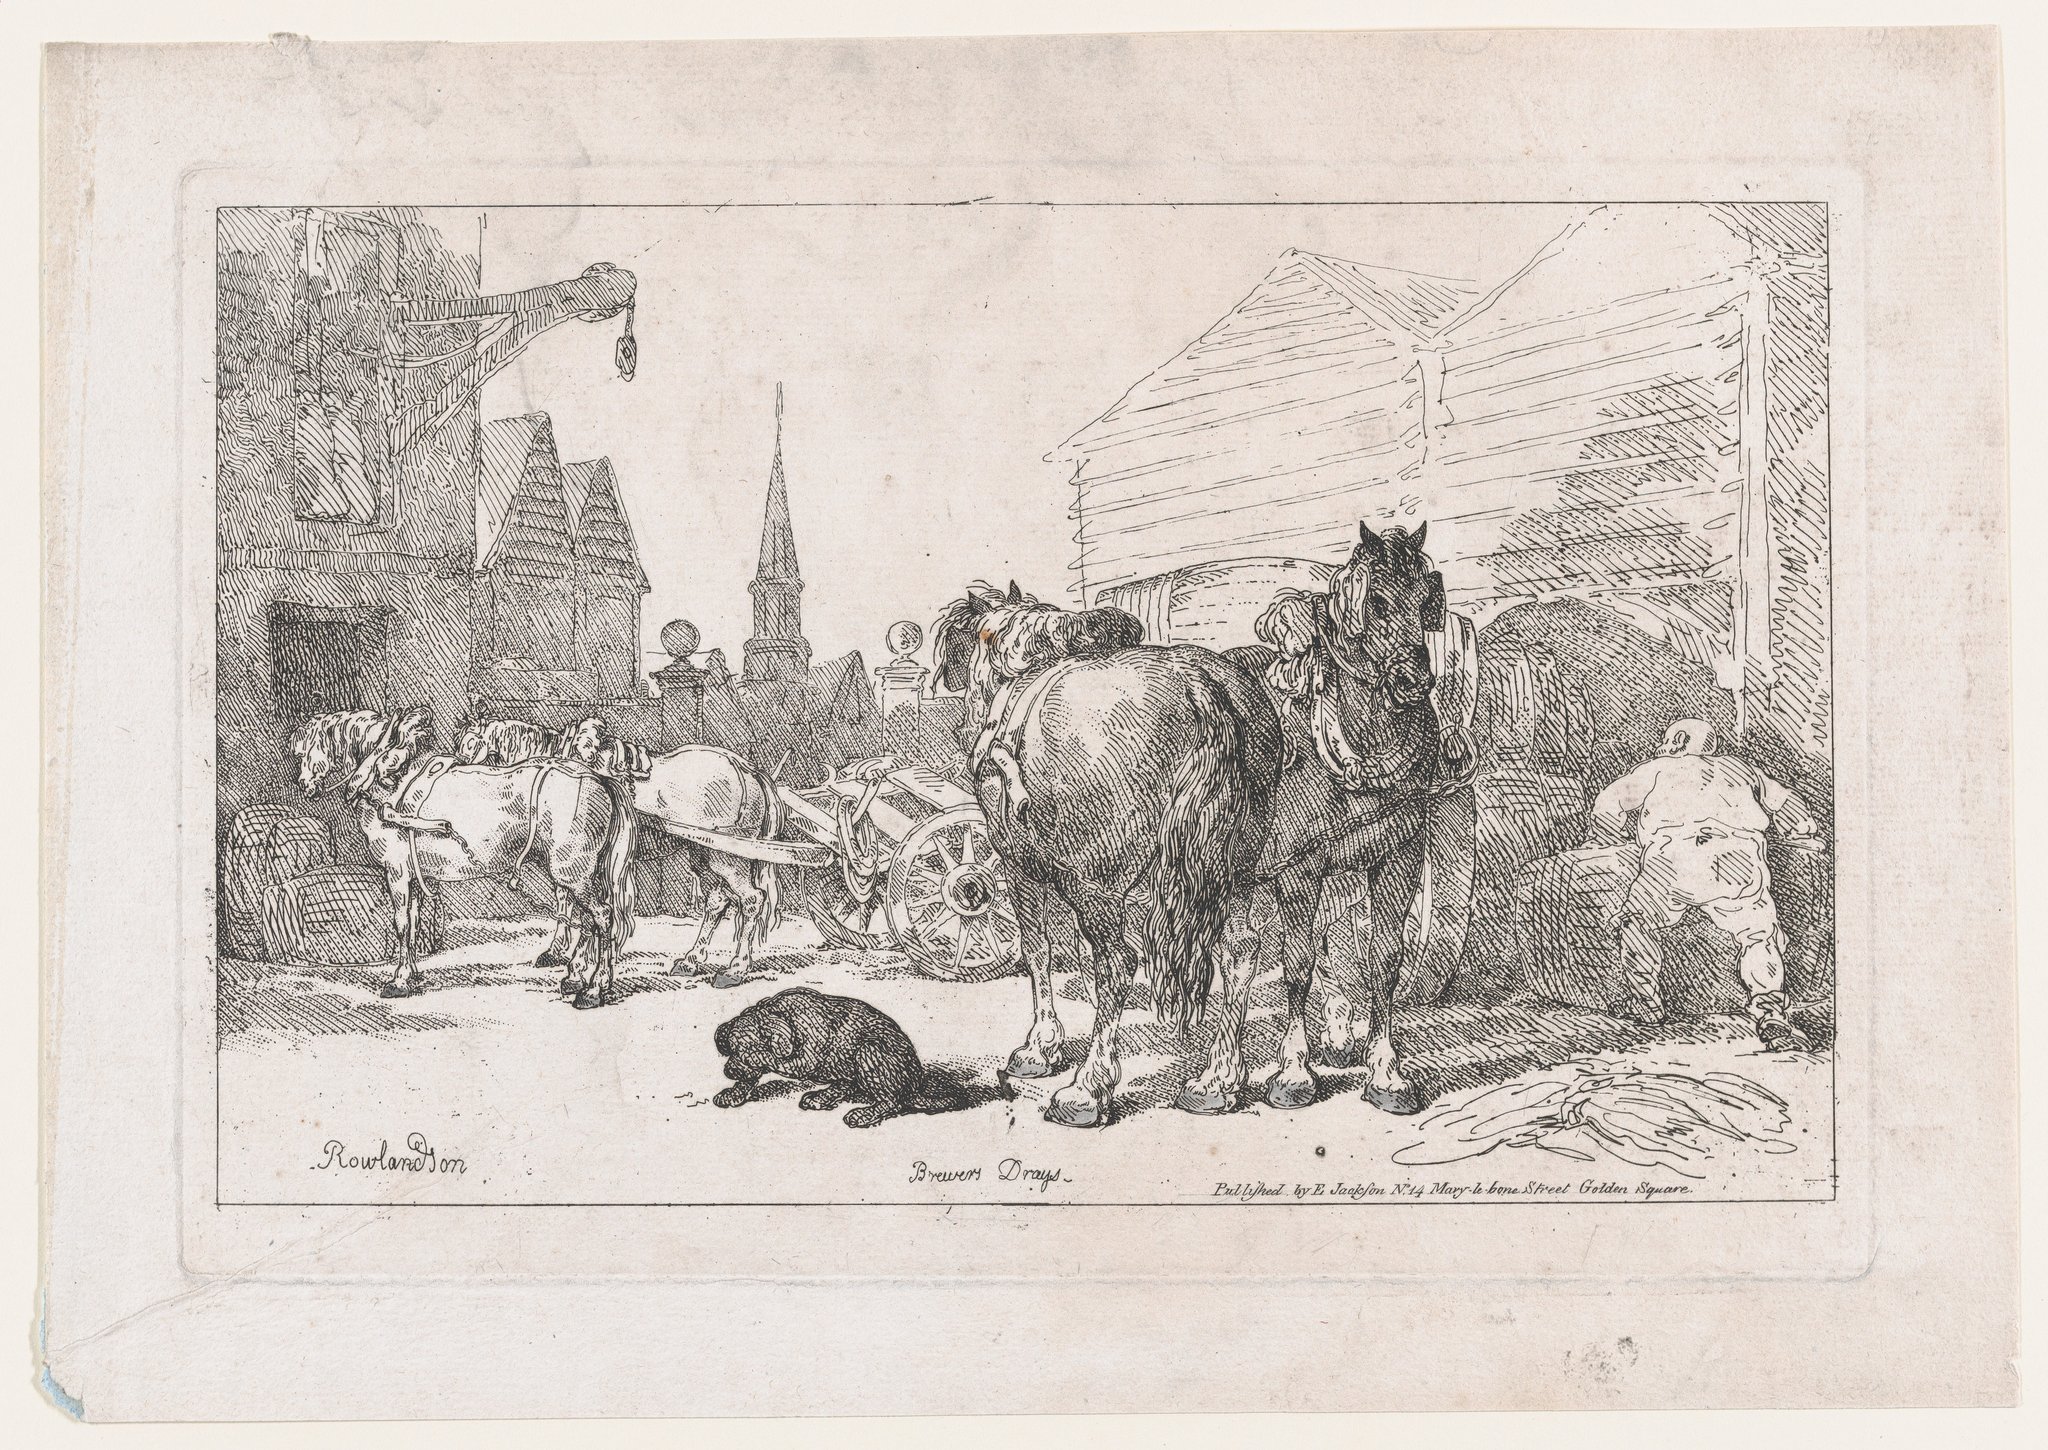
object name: print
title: Brewers Drays, from The Rhedarium, or, A New Book of Horses and Carriages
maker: thomas rowlandson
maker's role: artist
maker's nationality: british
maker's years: 1757-1827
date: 1784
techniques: etching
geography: london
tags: men,dogs,horses